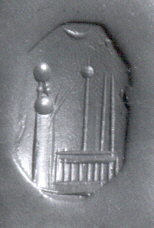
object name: stamp seal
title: Stamp seal (octagonal pyramid) with cultic scene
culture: assyro-babylonian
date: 700-501 BCE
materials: stone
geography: mesopotamia